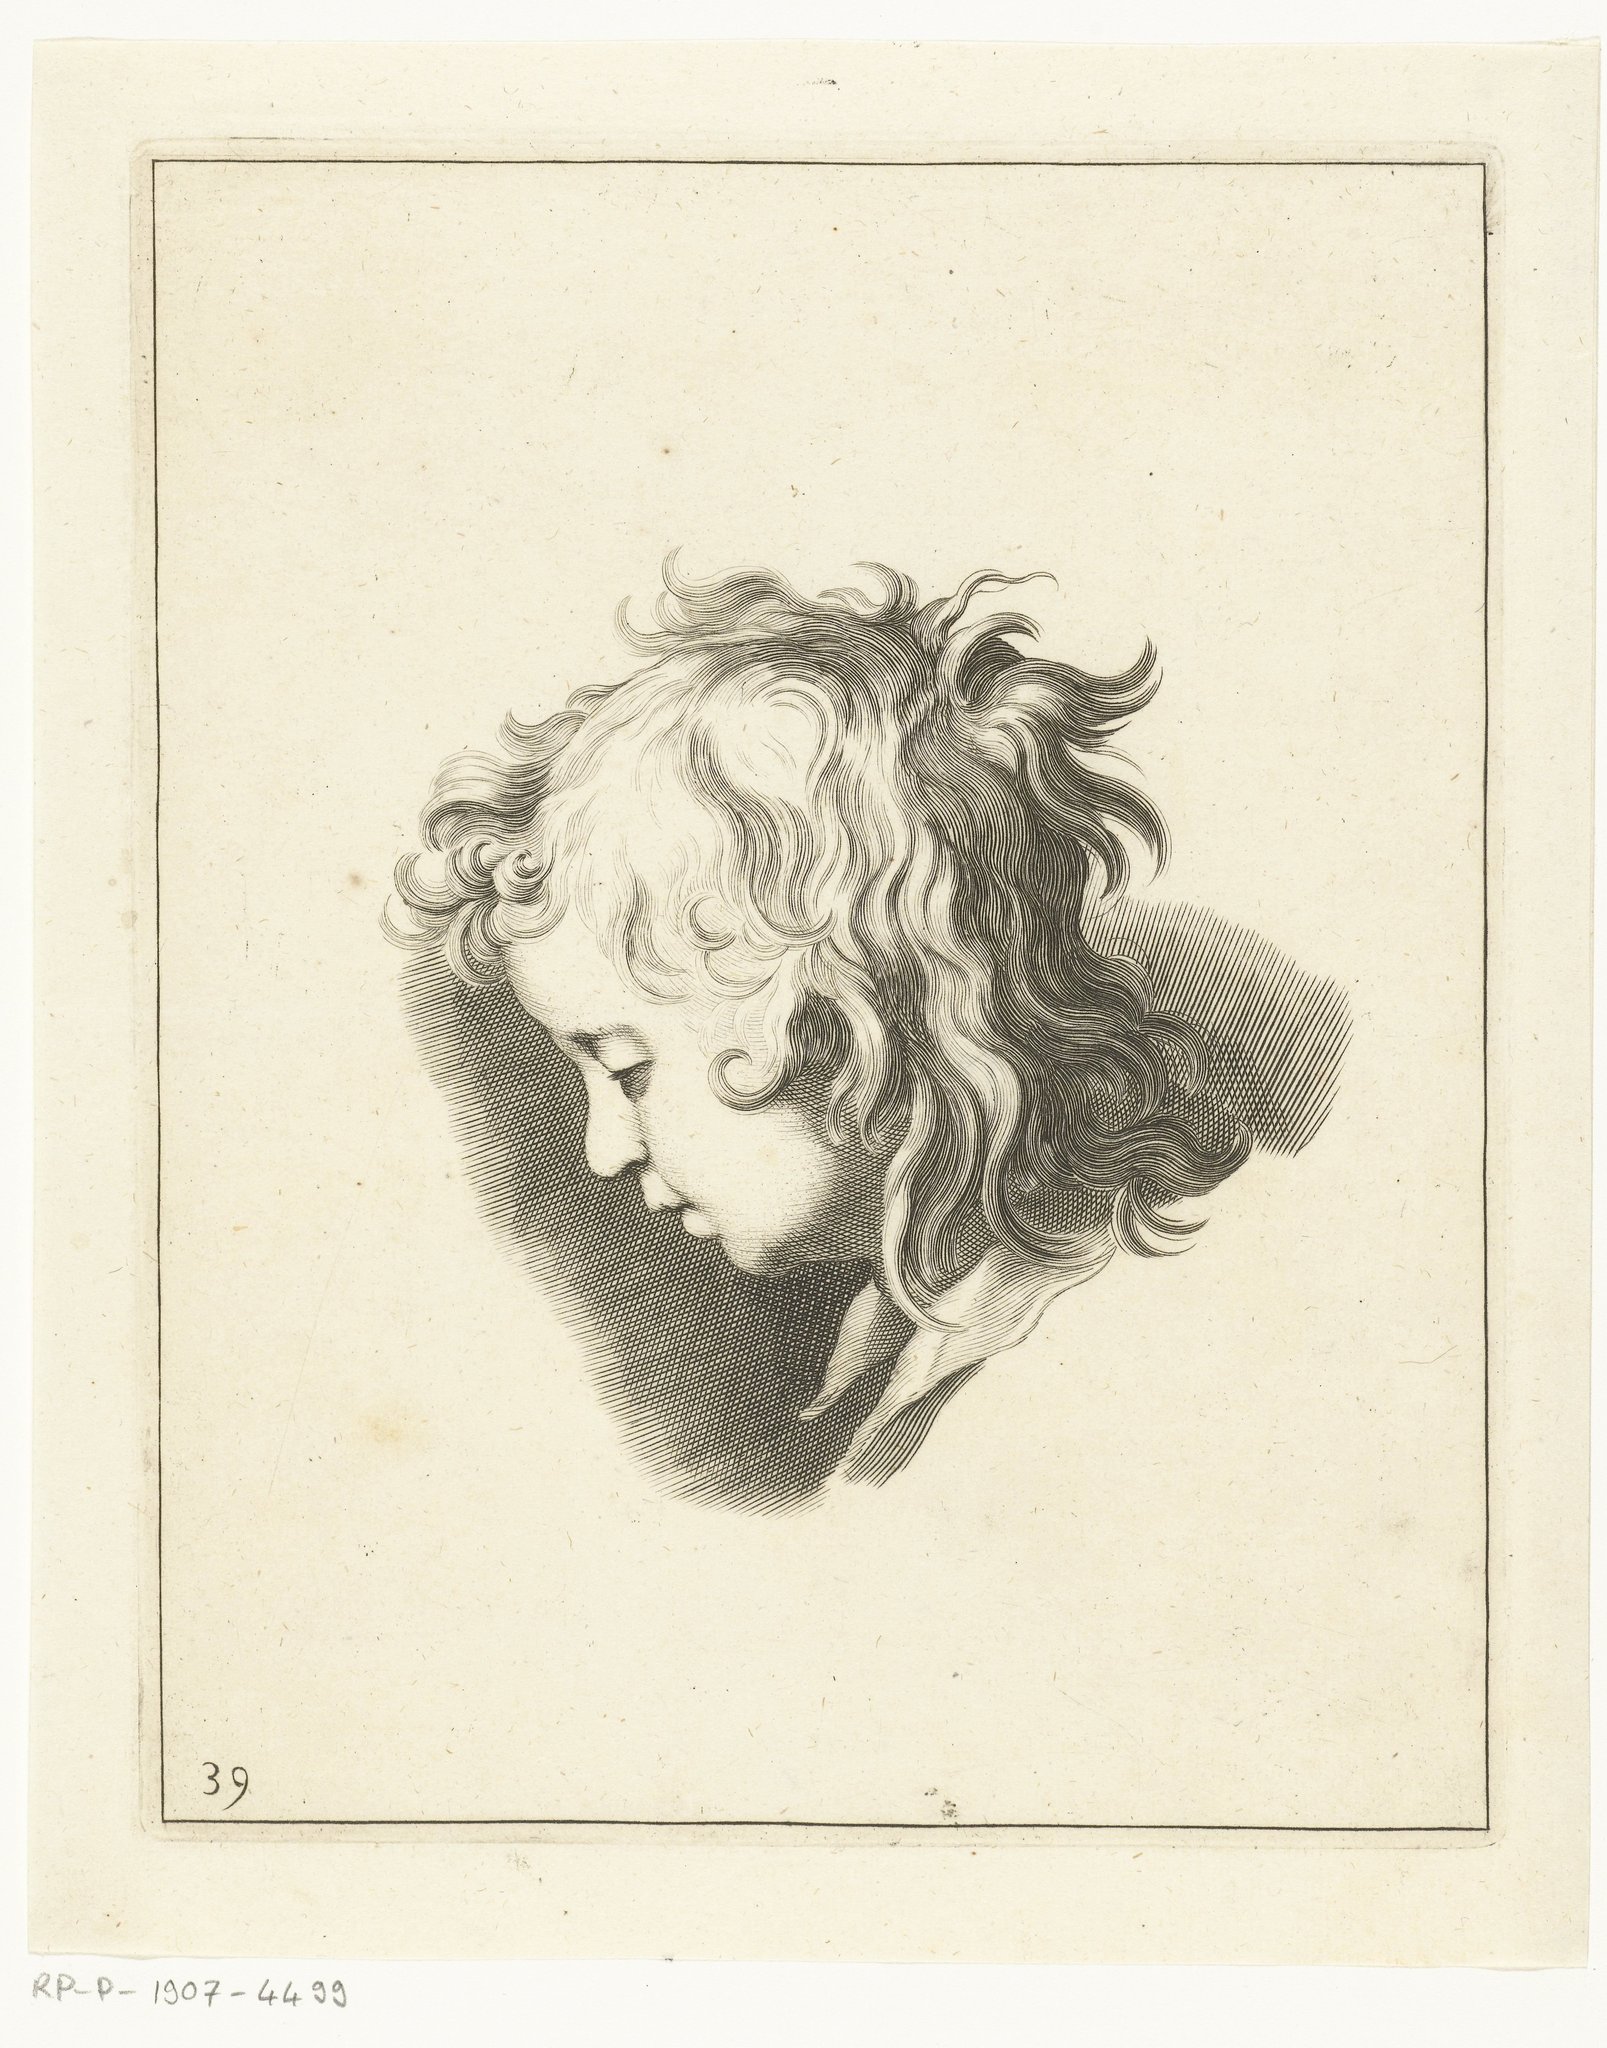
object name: print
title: Hoofd van een kind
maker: frederick bloemaert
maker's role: print maker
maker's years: 1614-1669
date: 1679-1701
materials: paper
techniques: engraving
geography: utrecht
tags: human beings (legendary or not) of abnormal proportions, size, strength, etc. (+ head, face)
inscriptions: collector's mark: Lugt 2228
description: Zijaanzicht van het hoofd van een kind met bijna-gesloten ogen en krullend haar.